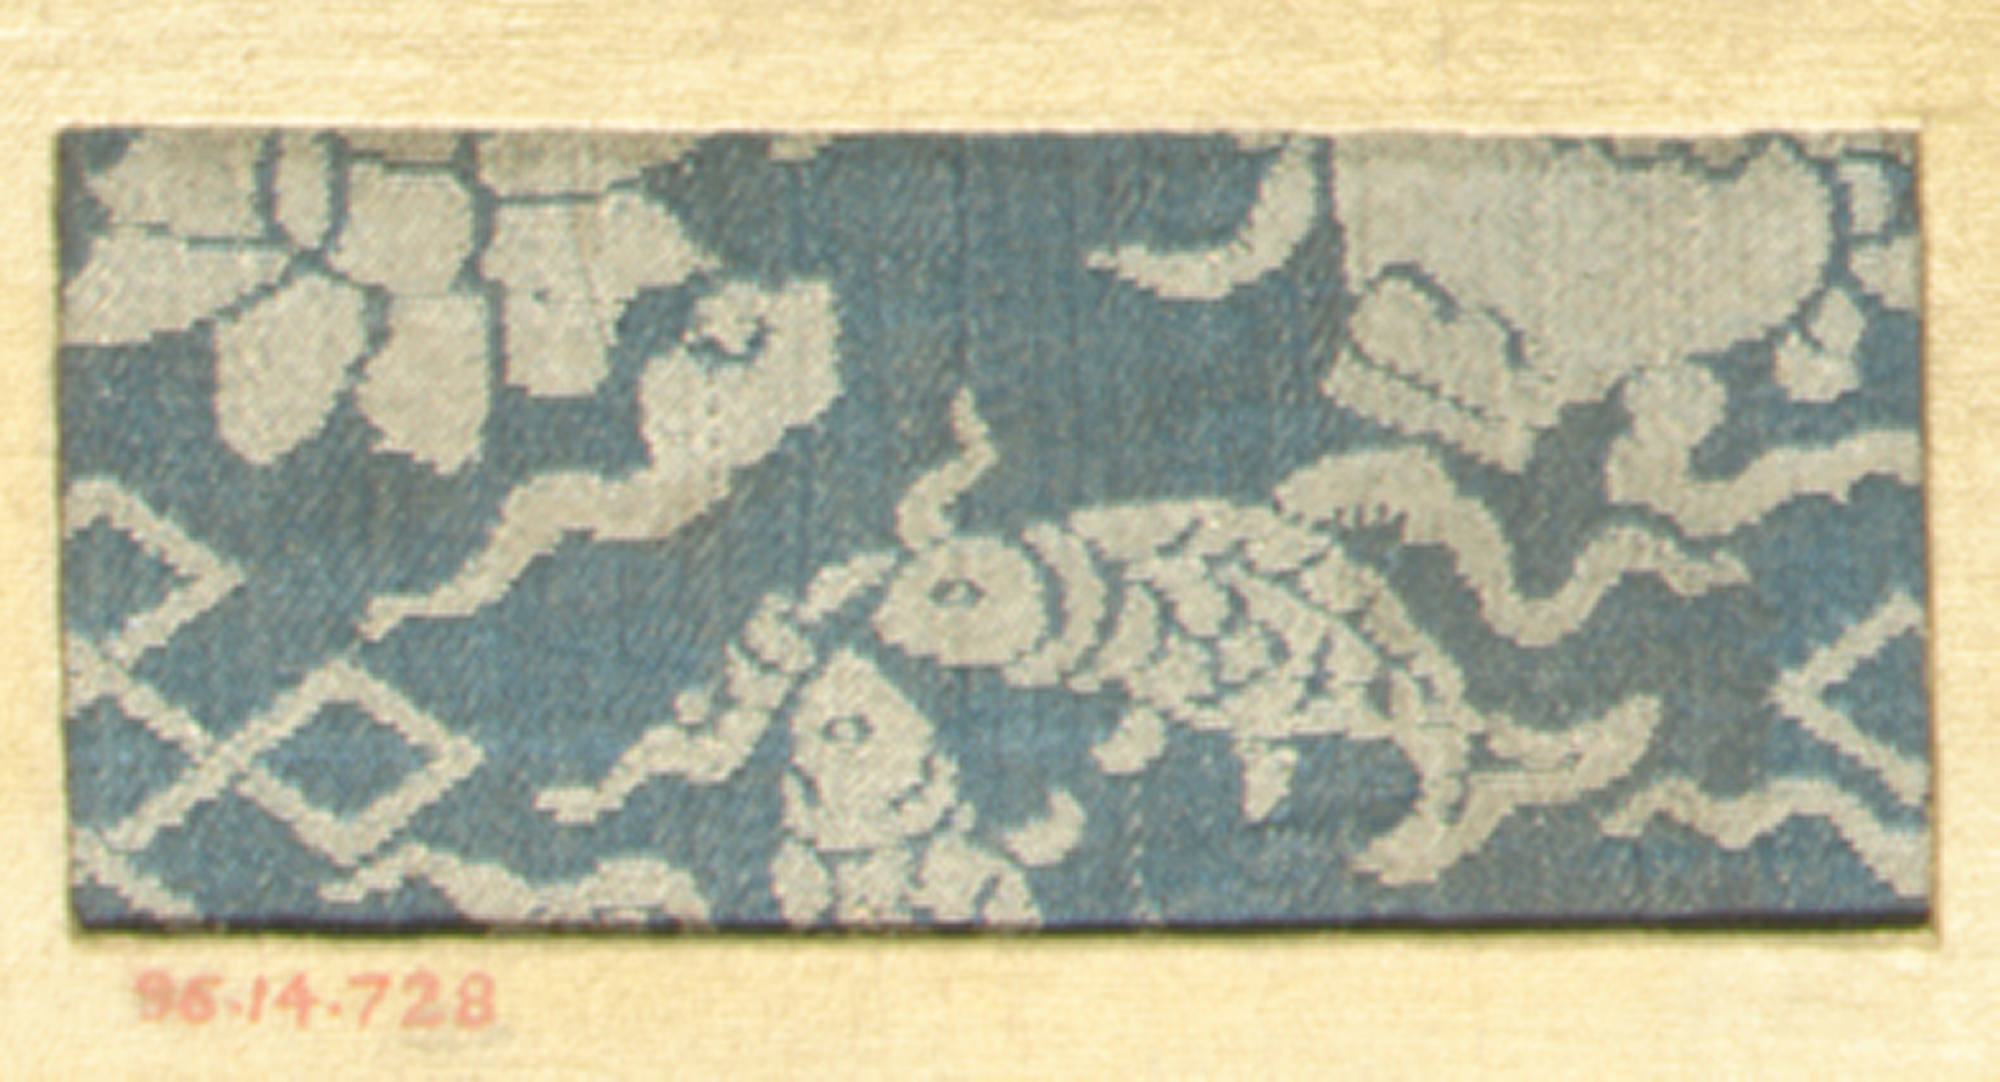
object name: piece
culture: japanese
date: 1701-1900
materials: silk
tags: fish